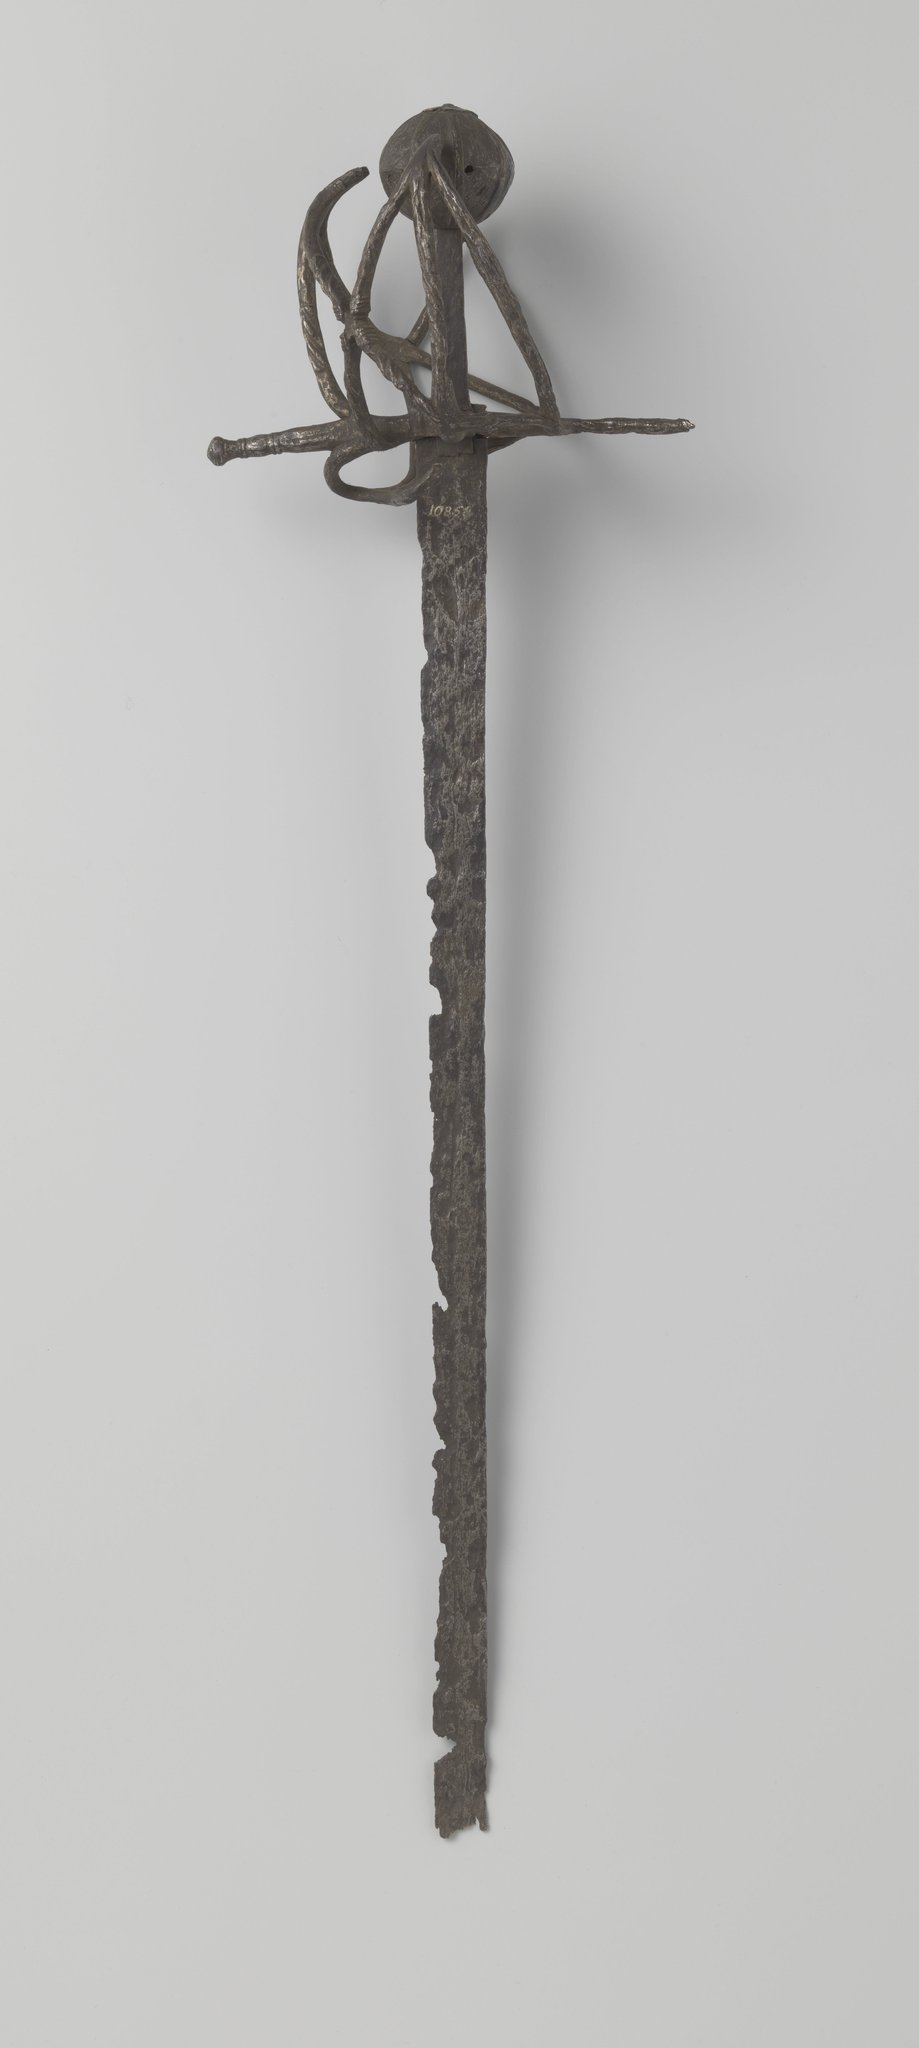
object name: sword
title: Degen met ijzeren korf en kruisstang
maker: Anonymous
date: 1575-1600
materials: copper, iron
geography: europe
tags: europe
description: Degen met ijzeren gevest: klinkknop. Knop met koperen banden, angel, pareerstang met knop, korfgevest bestaand uit gedraaide beugels, enkele welke zich elkaar kruisen. IJzeren rechte kling. Geroest.